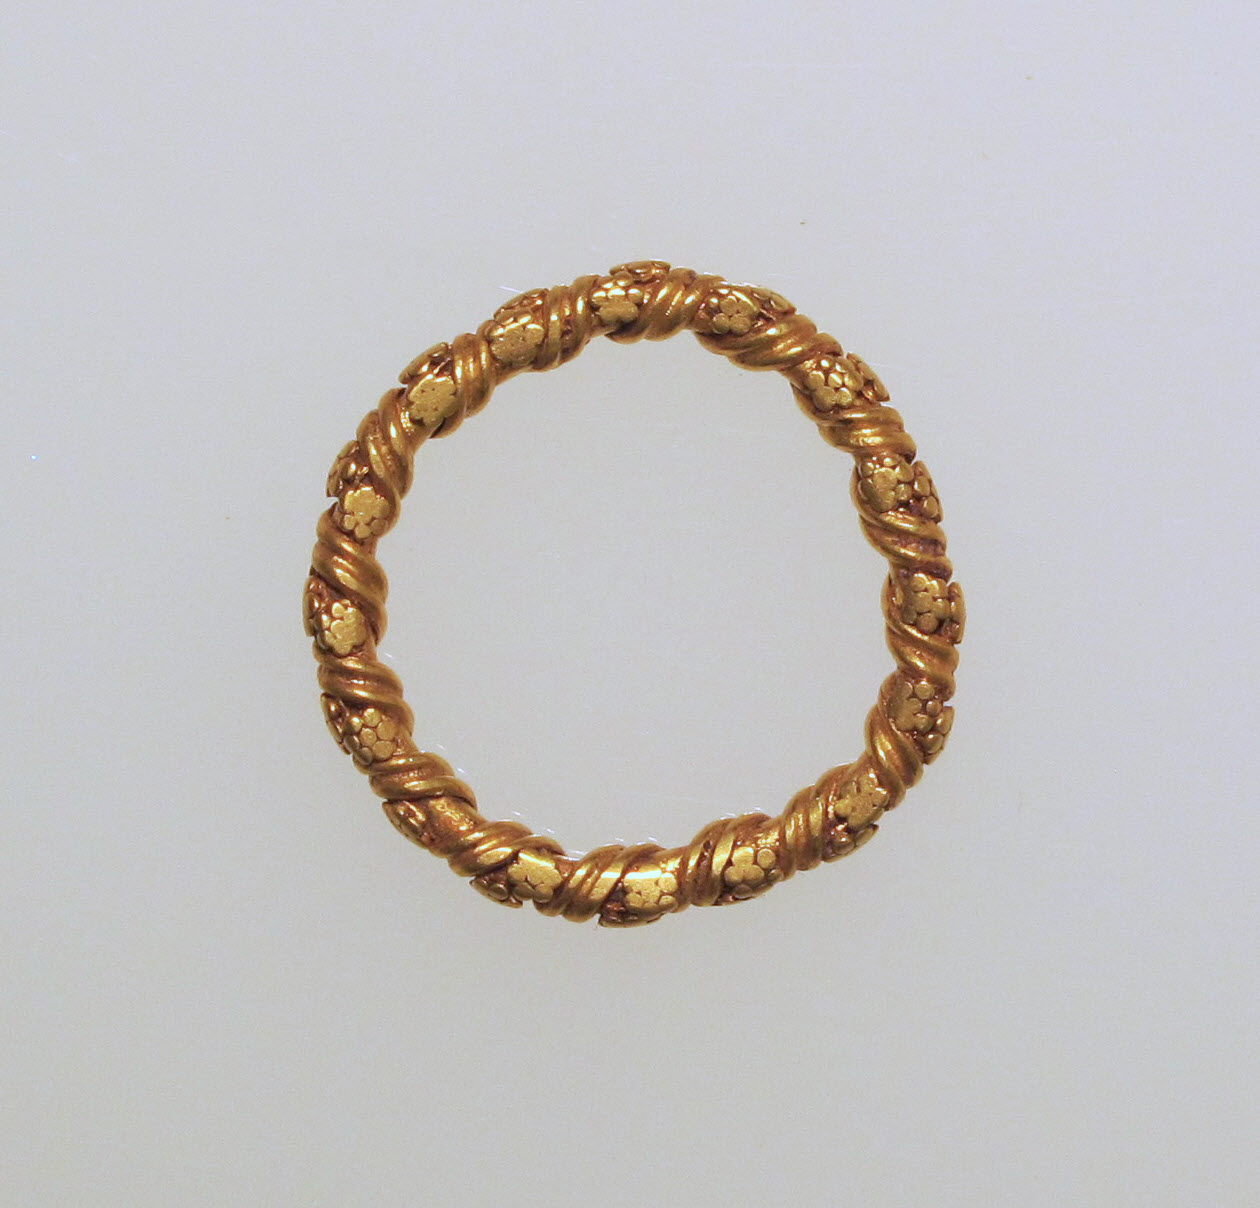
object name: ring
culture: roman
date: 670 BCE-330 CE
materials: gold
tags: flowers